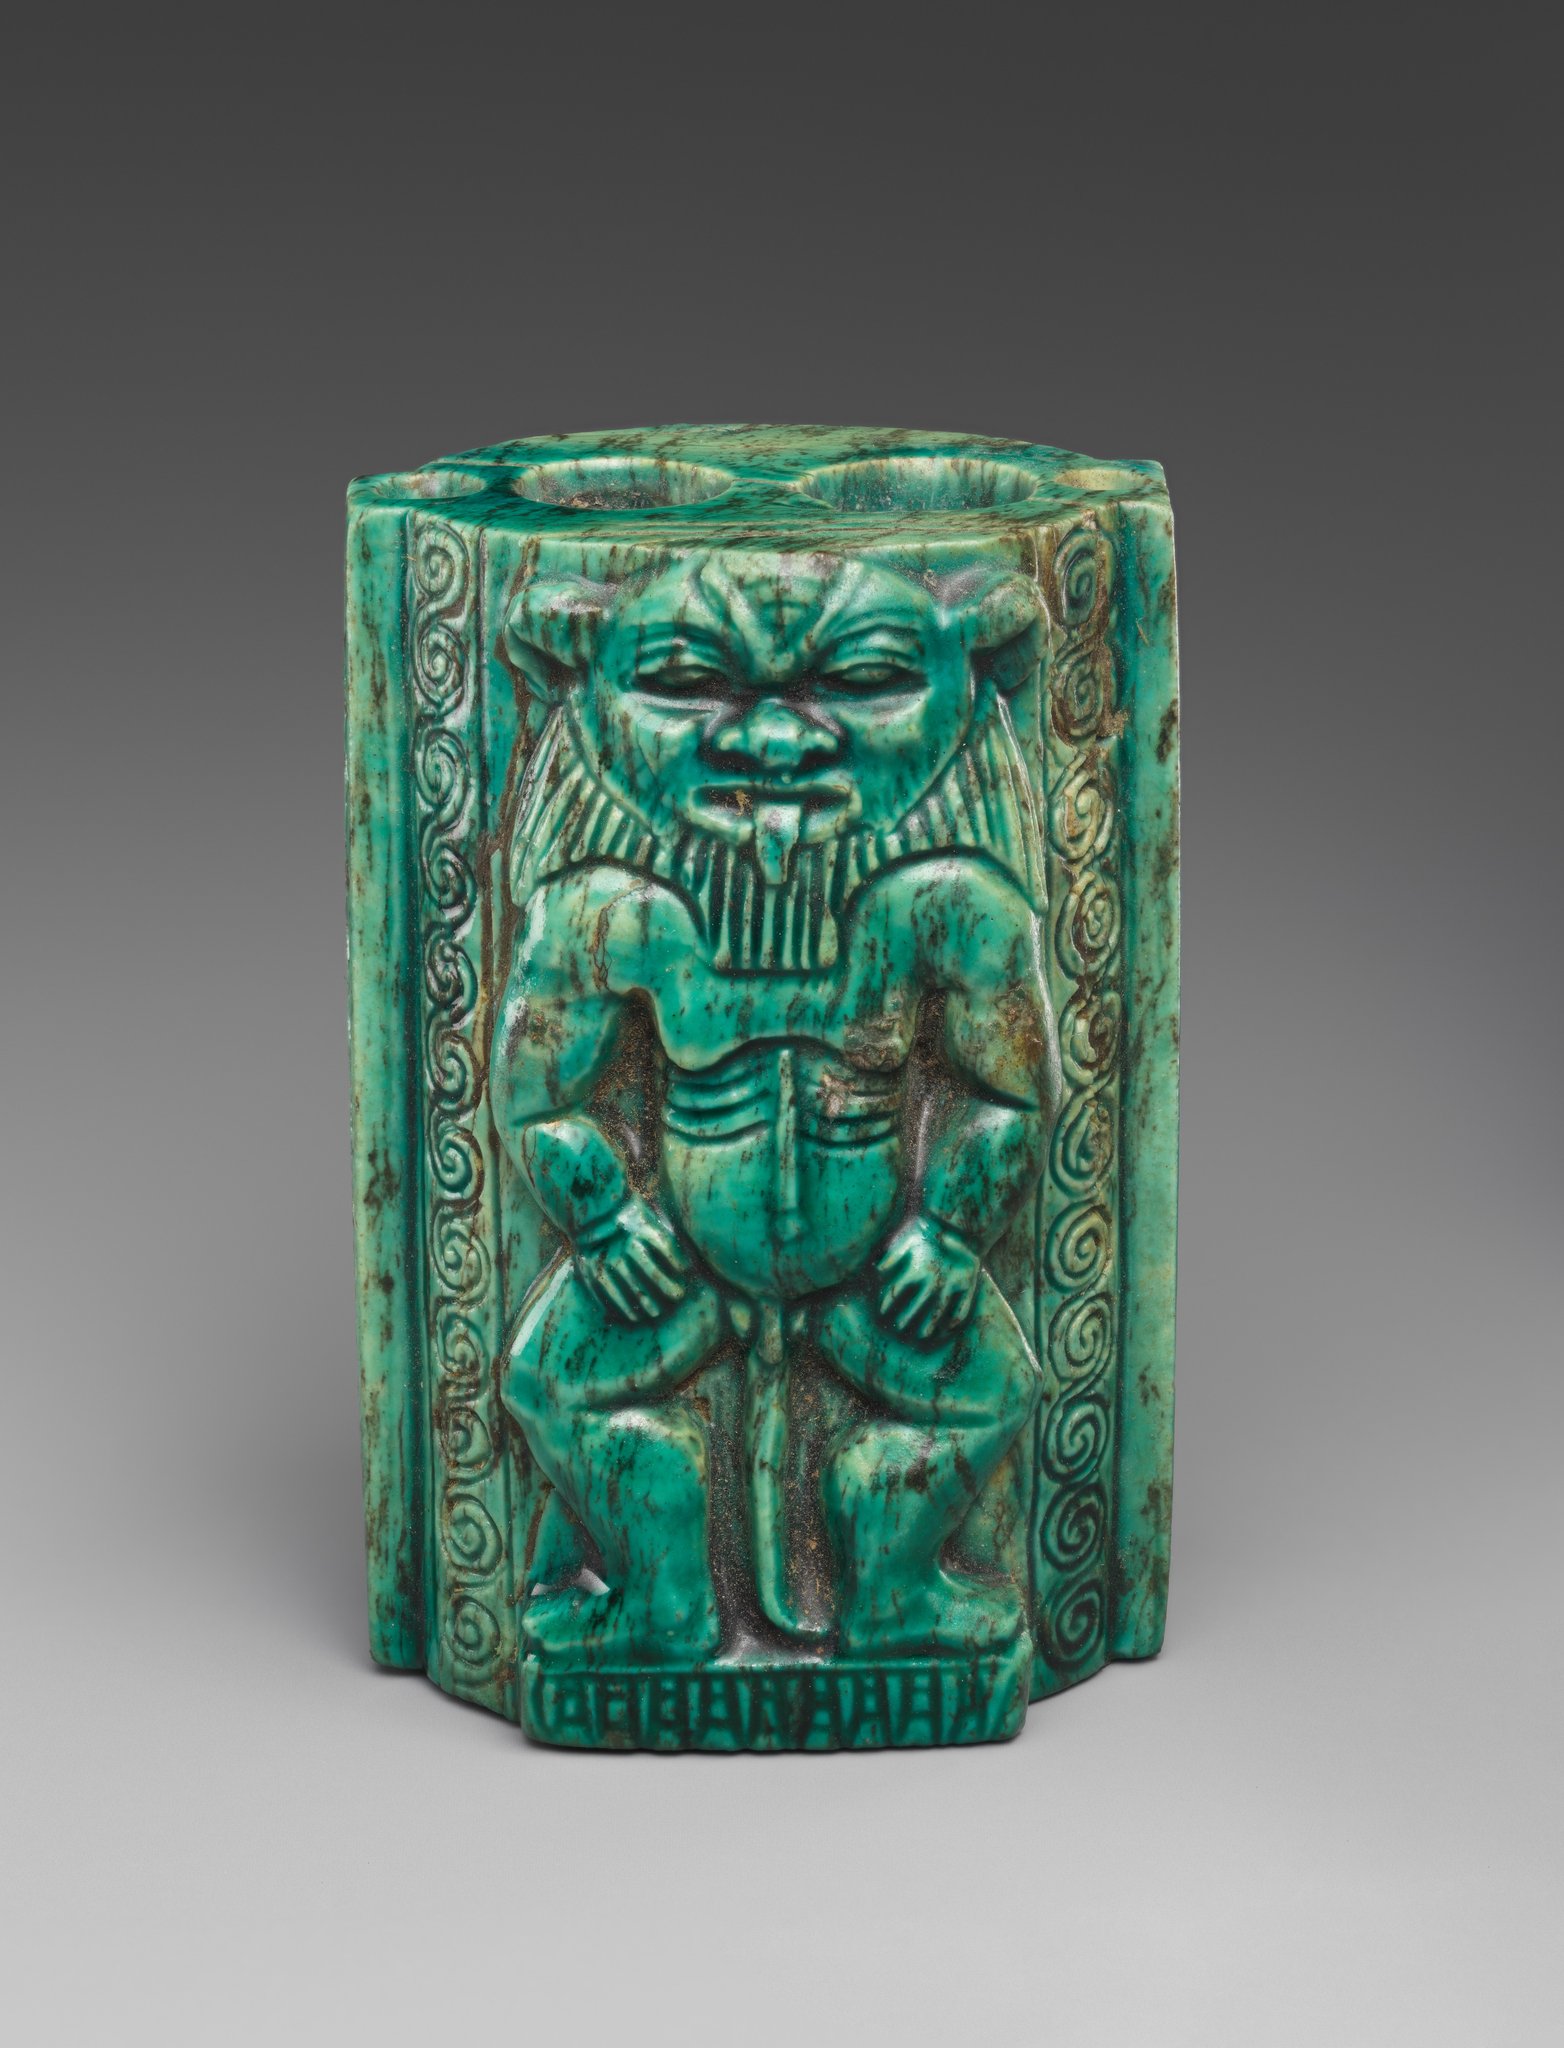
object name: kohl tube, double, be image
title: Cosmetic container decorated with a pair of Bes-images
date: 1550-1400 BCE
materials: stone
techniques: glazing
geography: egypt